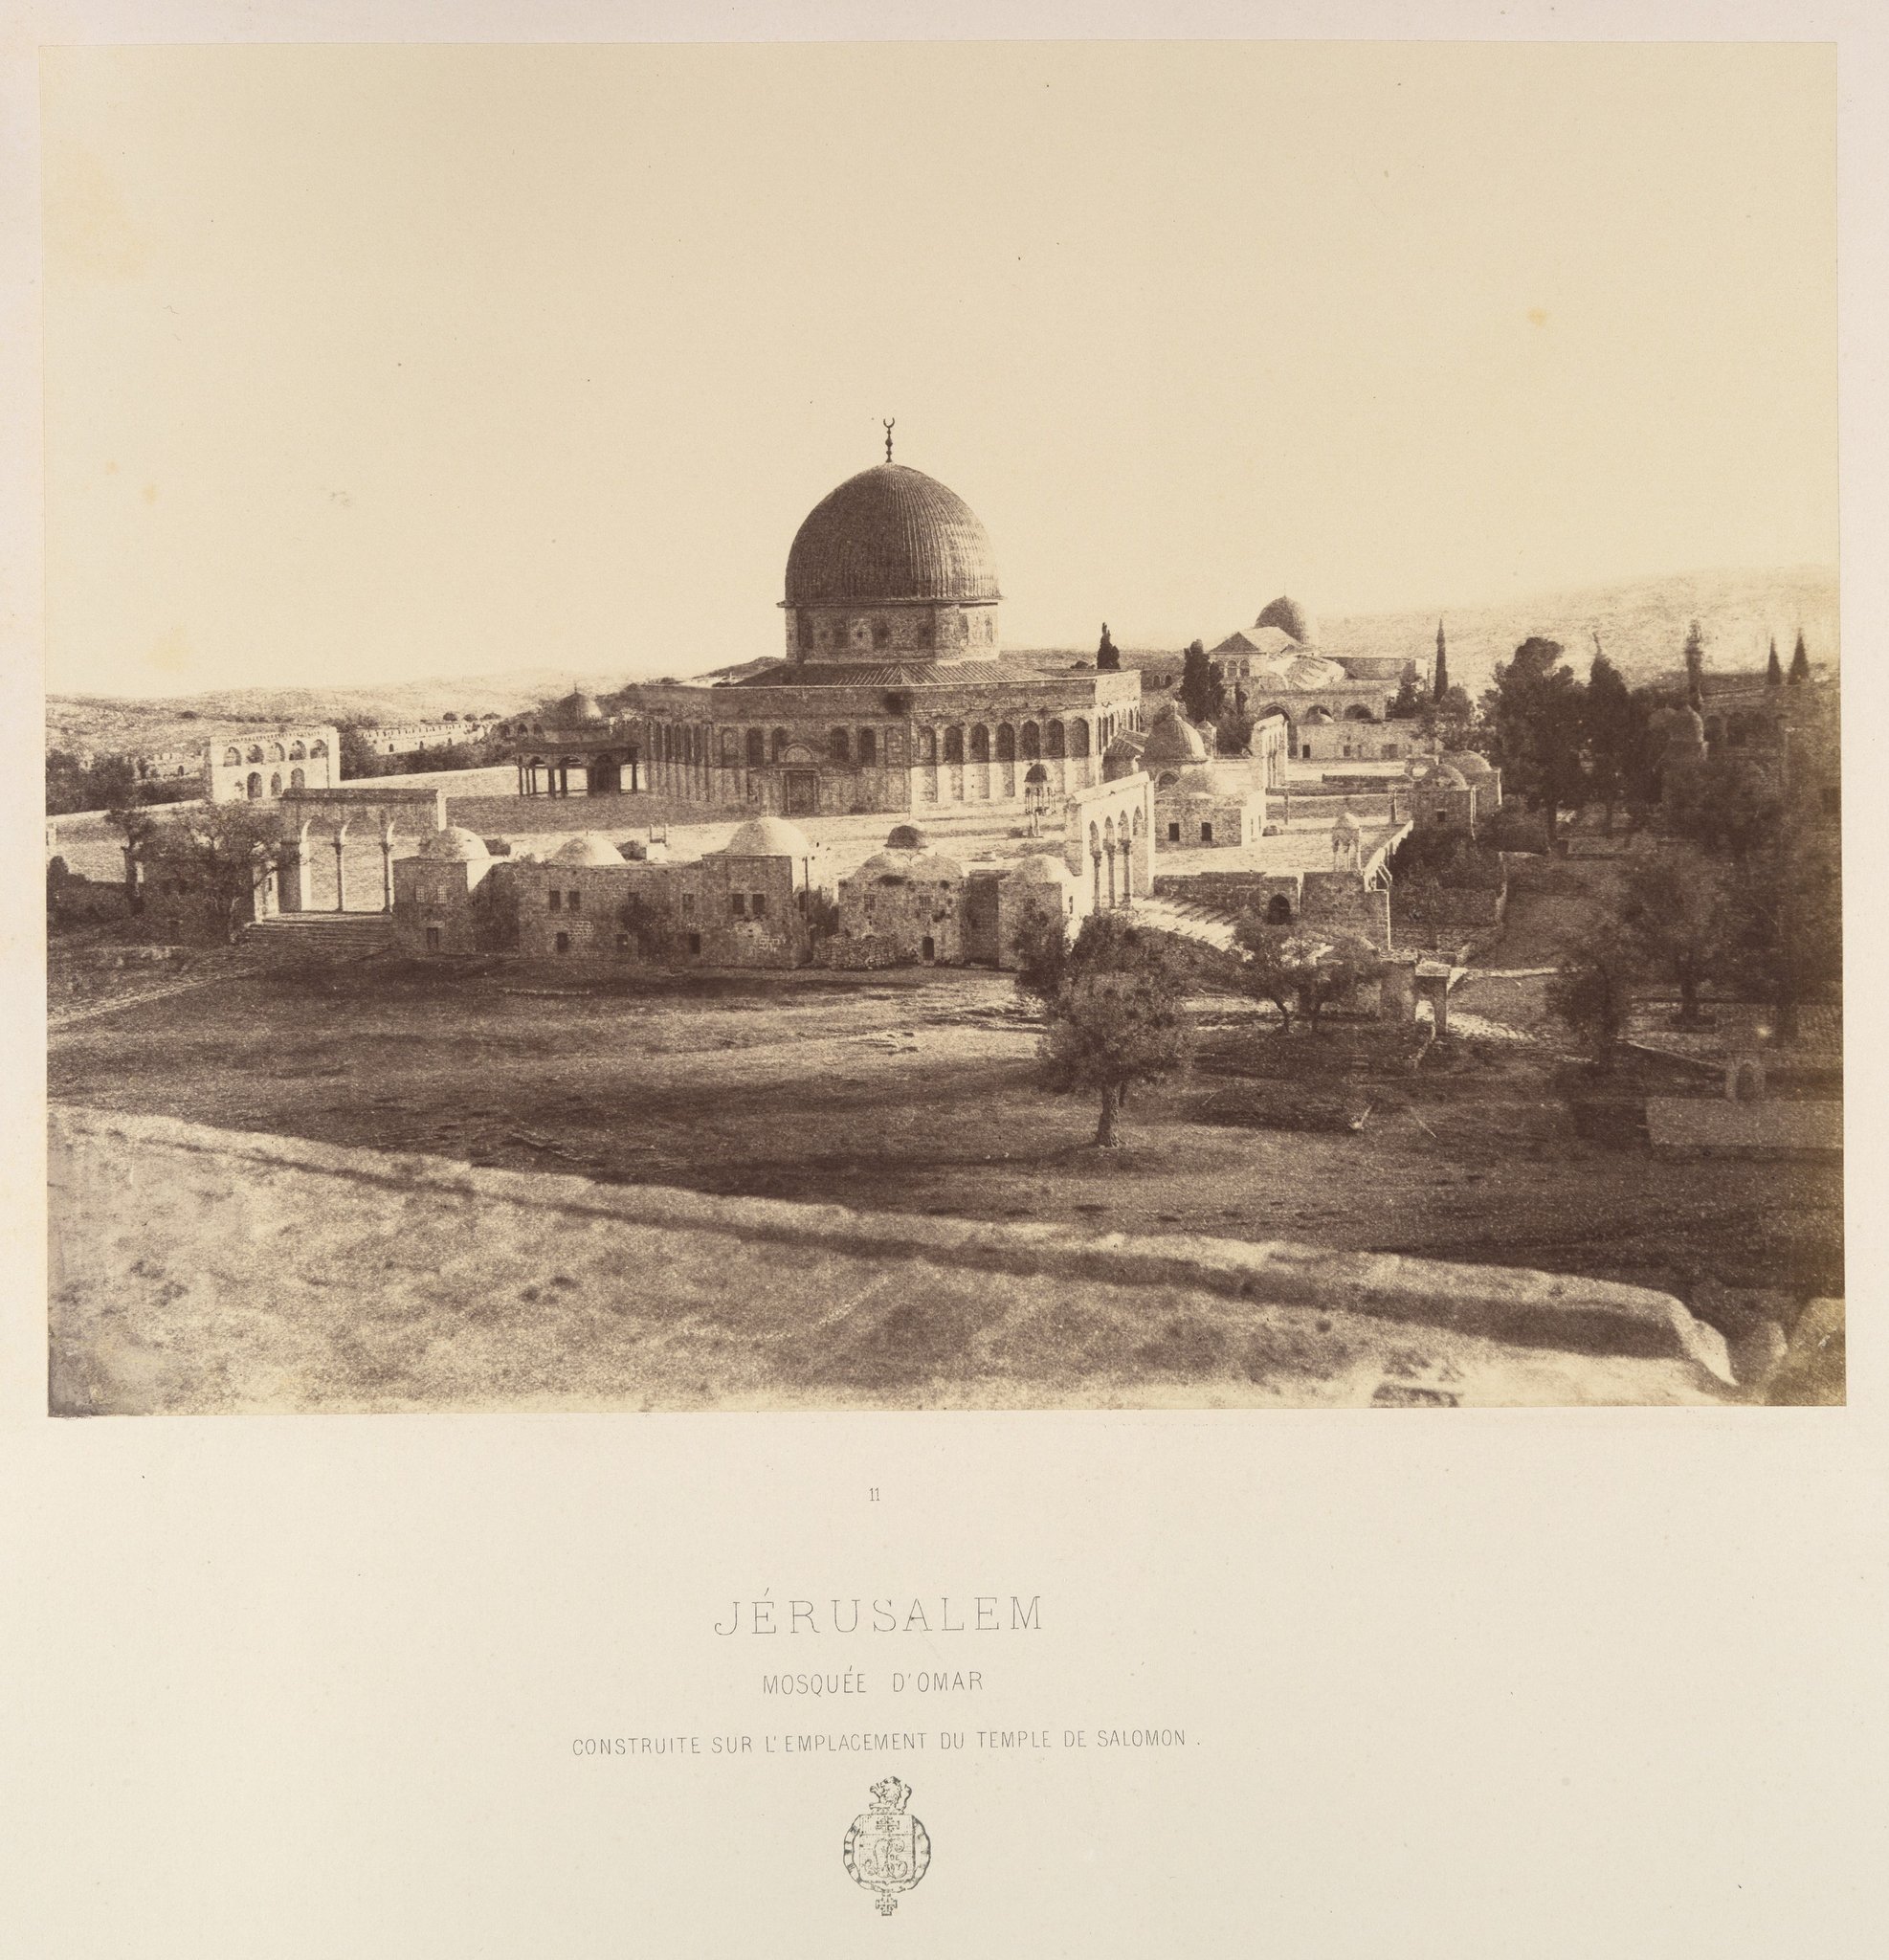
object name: photograph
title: Jérusalem. Mosquée d'Omar, construite sur l'emplacement su Temple de Salomon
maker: louis de clercq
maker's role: artist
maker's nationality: french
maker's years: 1837-1901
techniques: albumen silver print, paper negative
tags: mosques